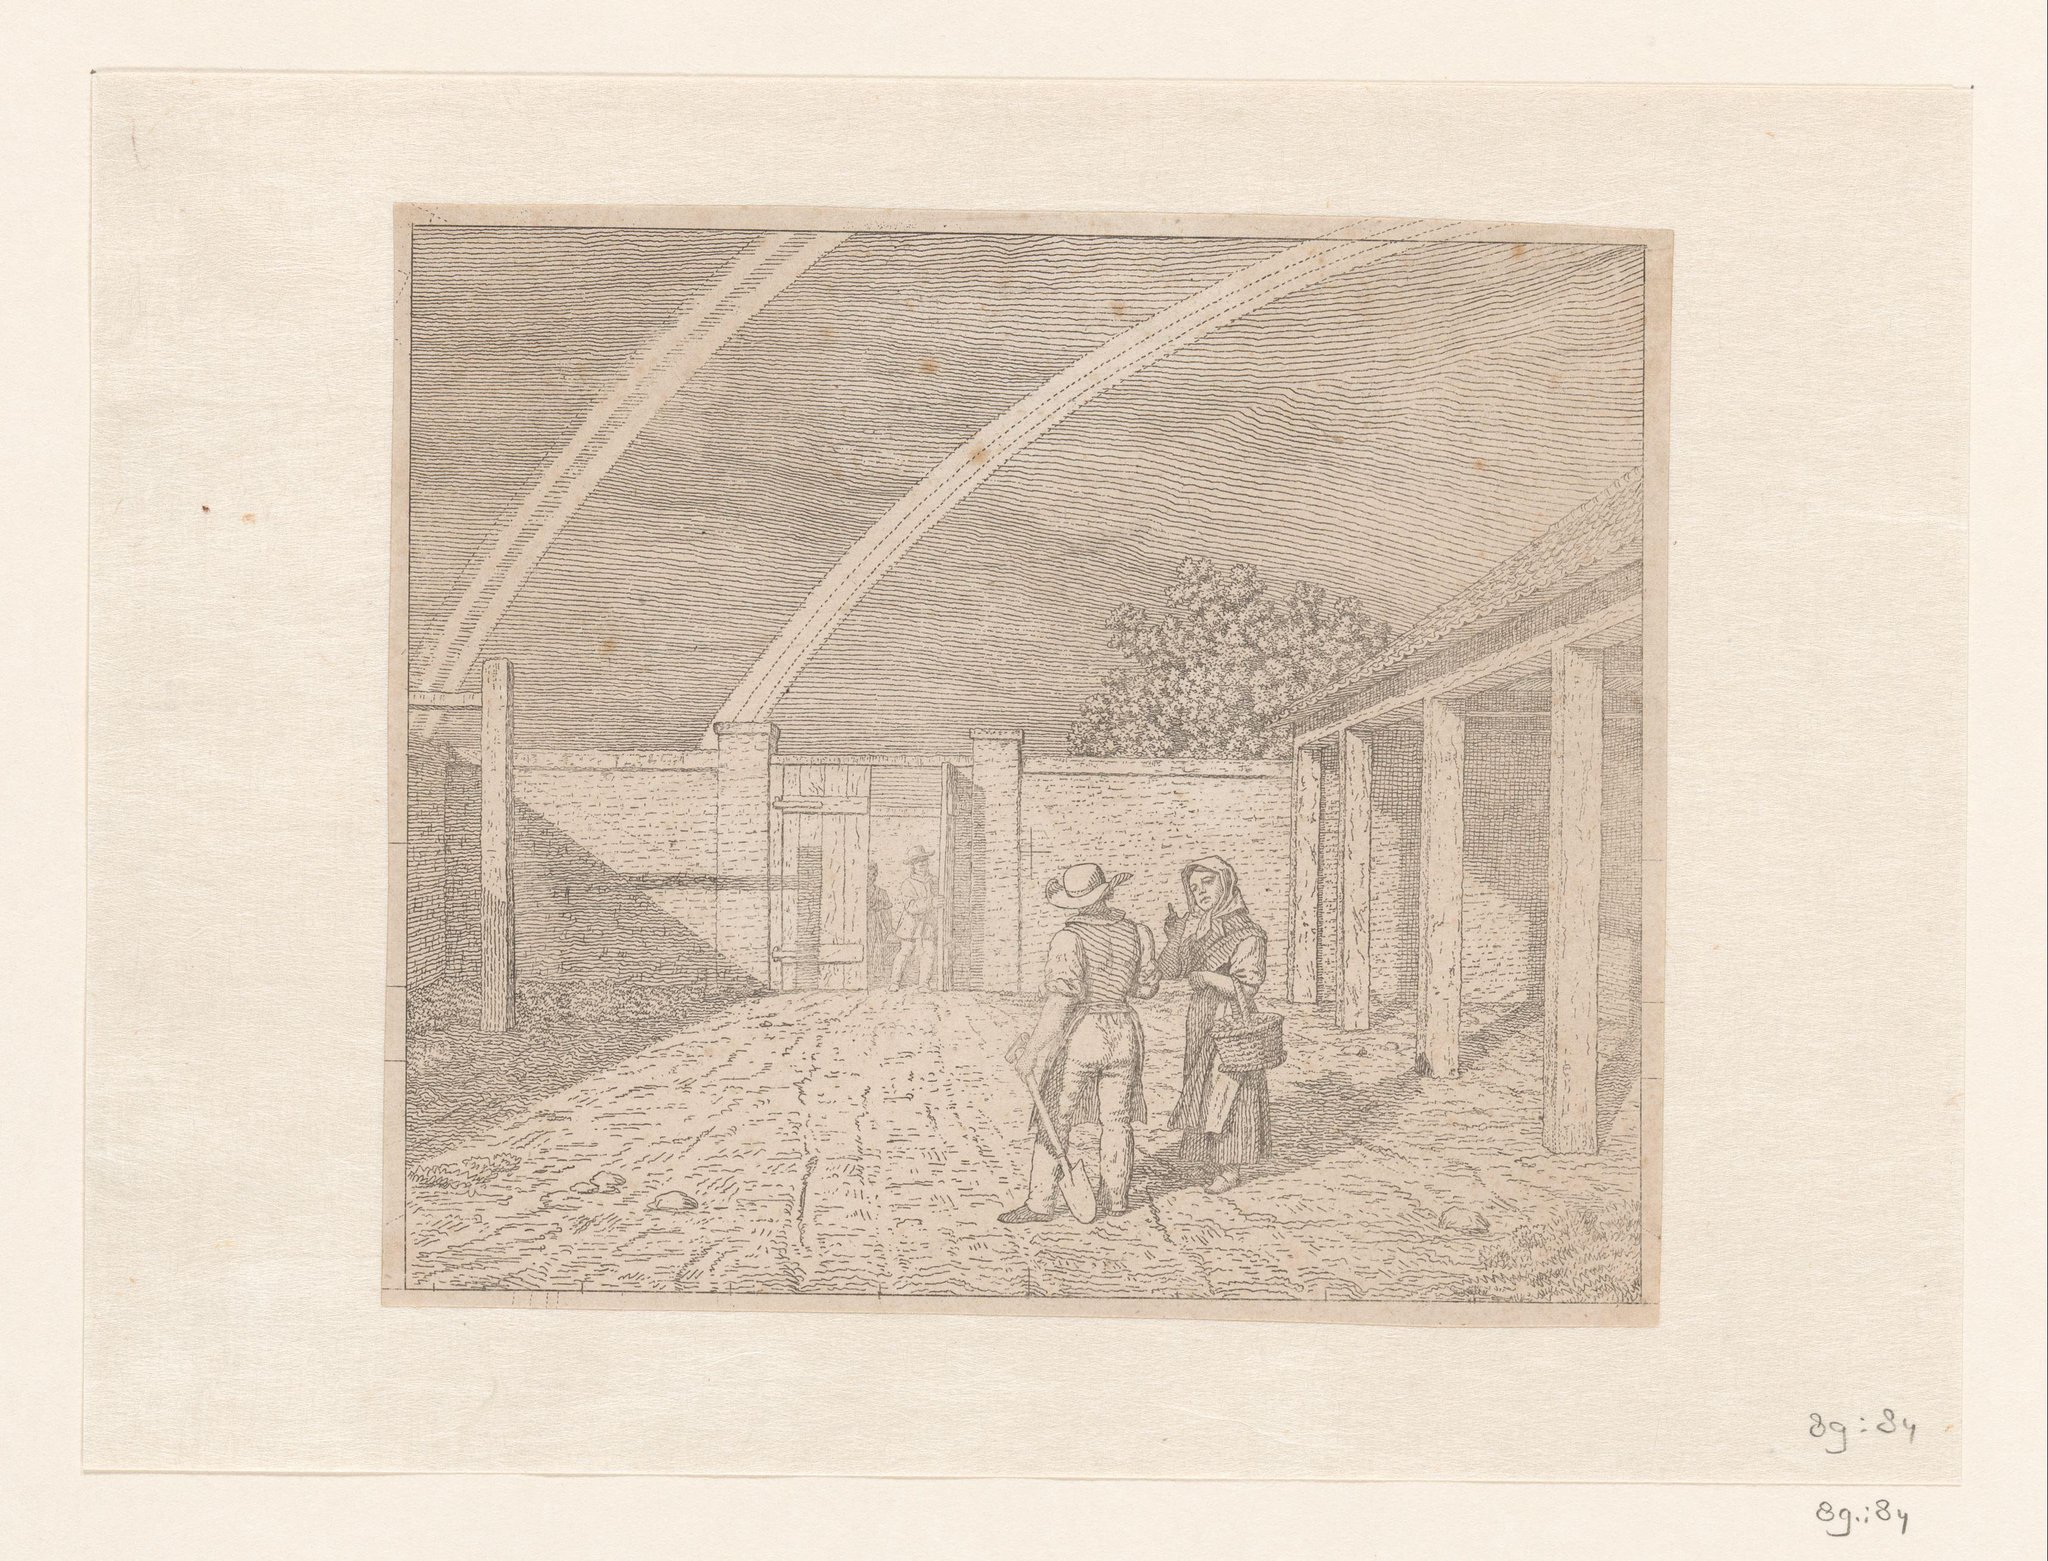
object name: print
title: Linear Perspective used in painting art, 1e versie, proefdruk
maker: christoffer wilhelm eckersberg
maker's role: painter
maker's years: 1783-1853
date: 1841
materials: paper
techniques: etching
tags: mathematical perspective, rainbow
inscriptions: collector's mark: Lugt 2760, collector's mark: Lugt 2228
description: Gezicht op een binnenplaats met enkele figuren. Dubbele regenboog in de lucht. Perspectiefstudie, staat voor de huplijnen.